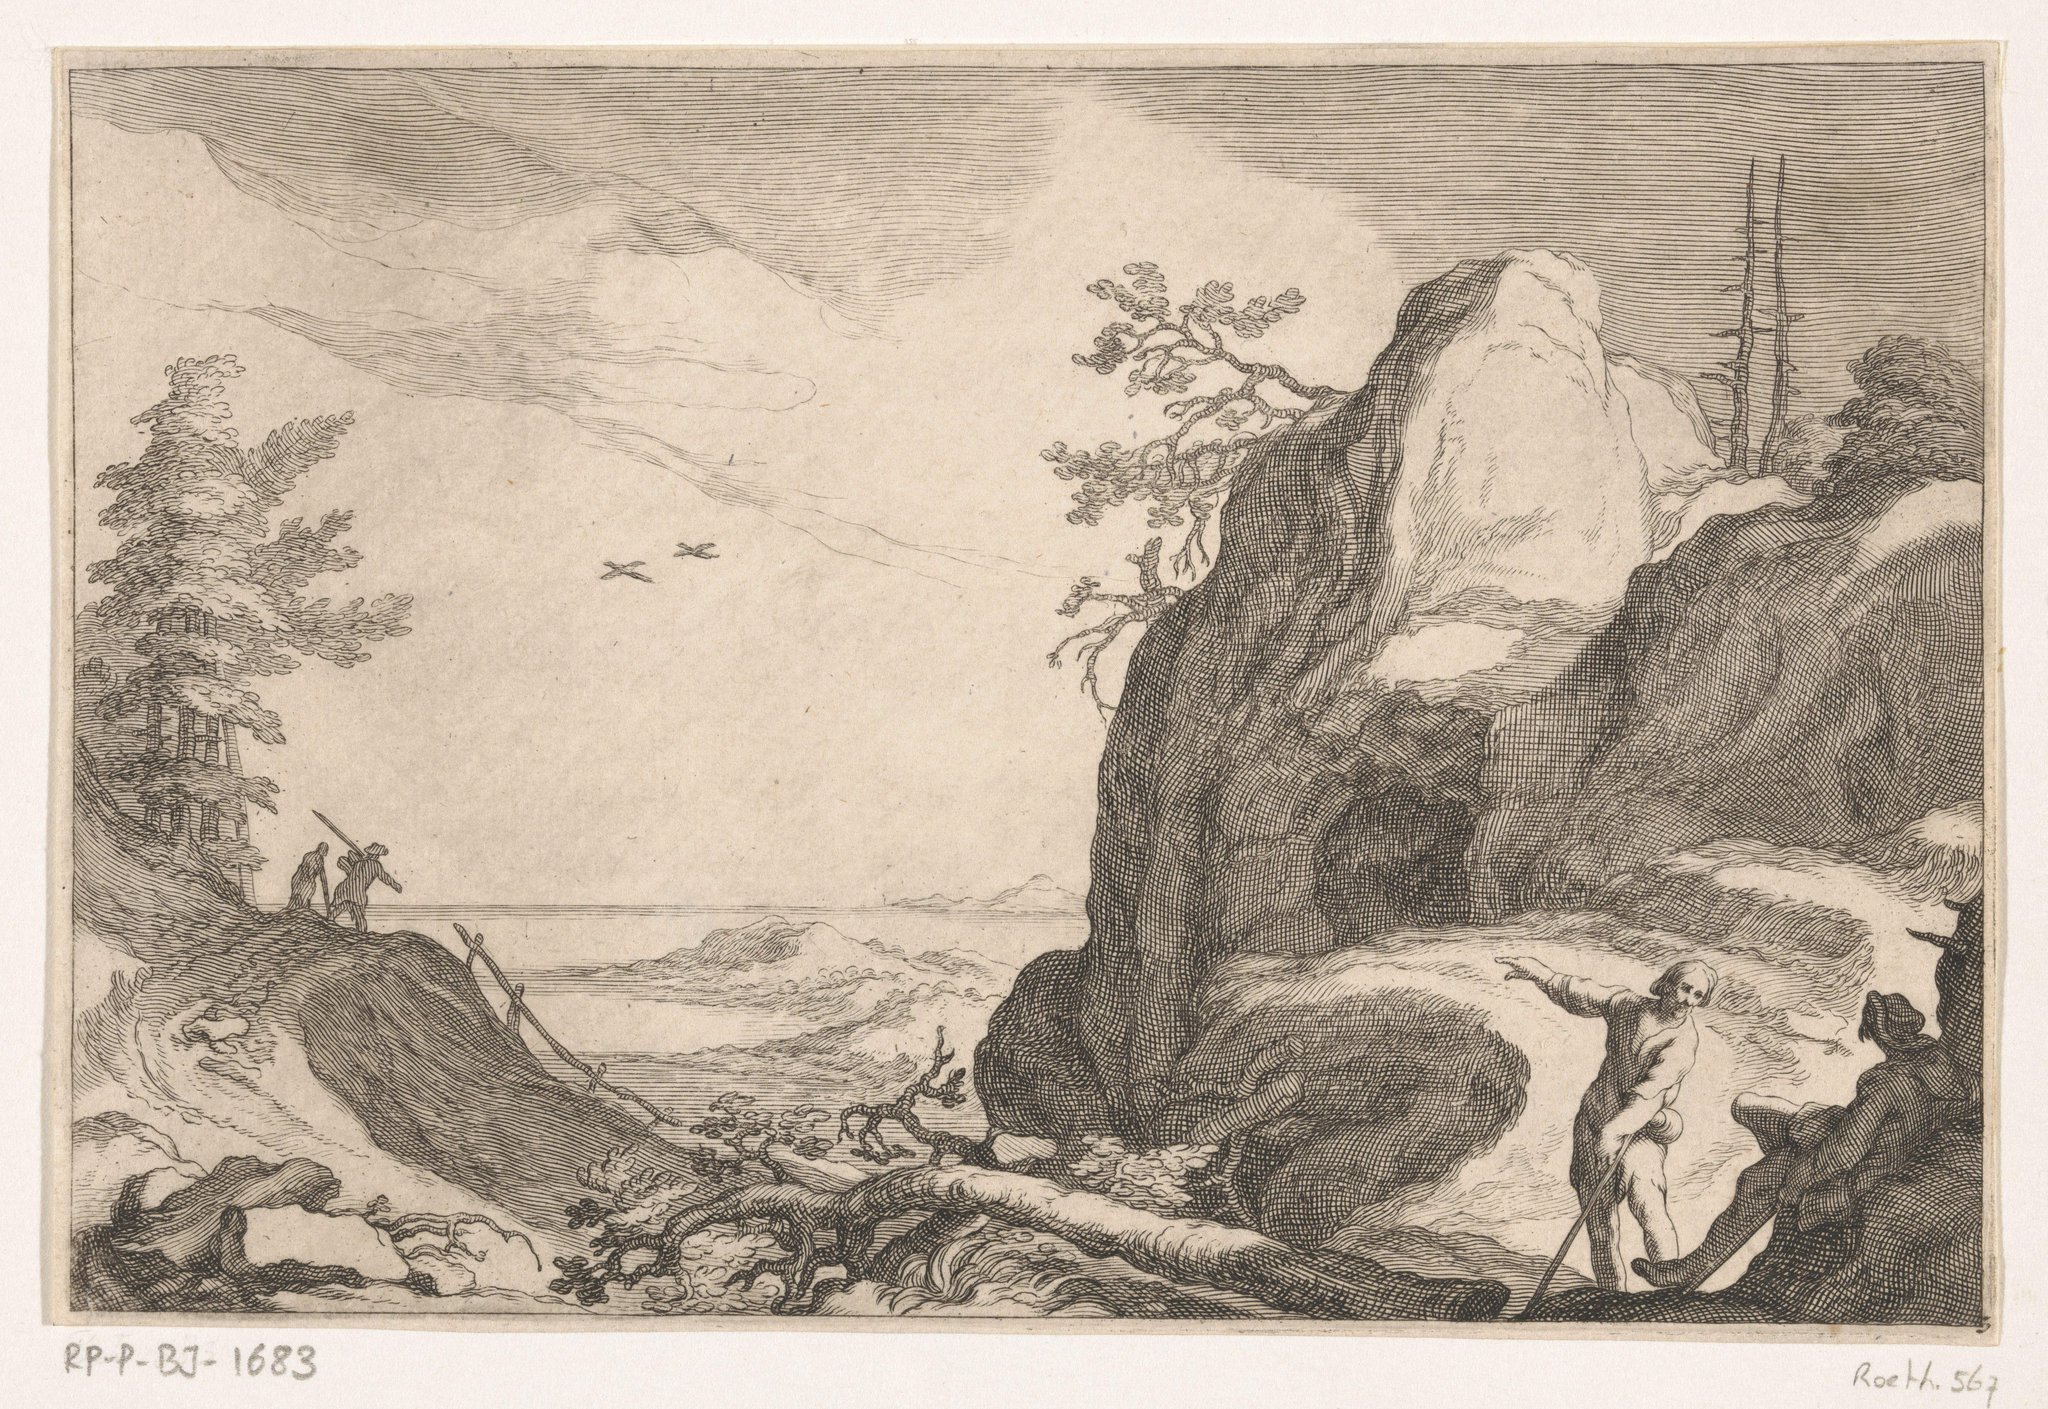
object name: print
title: Rotslandschap met de zee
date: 1647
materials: paper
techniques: engraving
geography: utrecht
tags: rocky coast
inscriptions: collector's mark: Lugt 240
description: Op de voorgrond zijn mannen aan het rusten of aan het werk. Achter de rotsen is de zee te zien. Deze prent maakt deel uit van een losse groep van elf prenten, waarvan enkel de nummers 1-6 (later?) genummerd zijn.